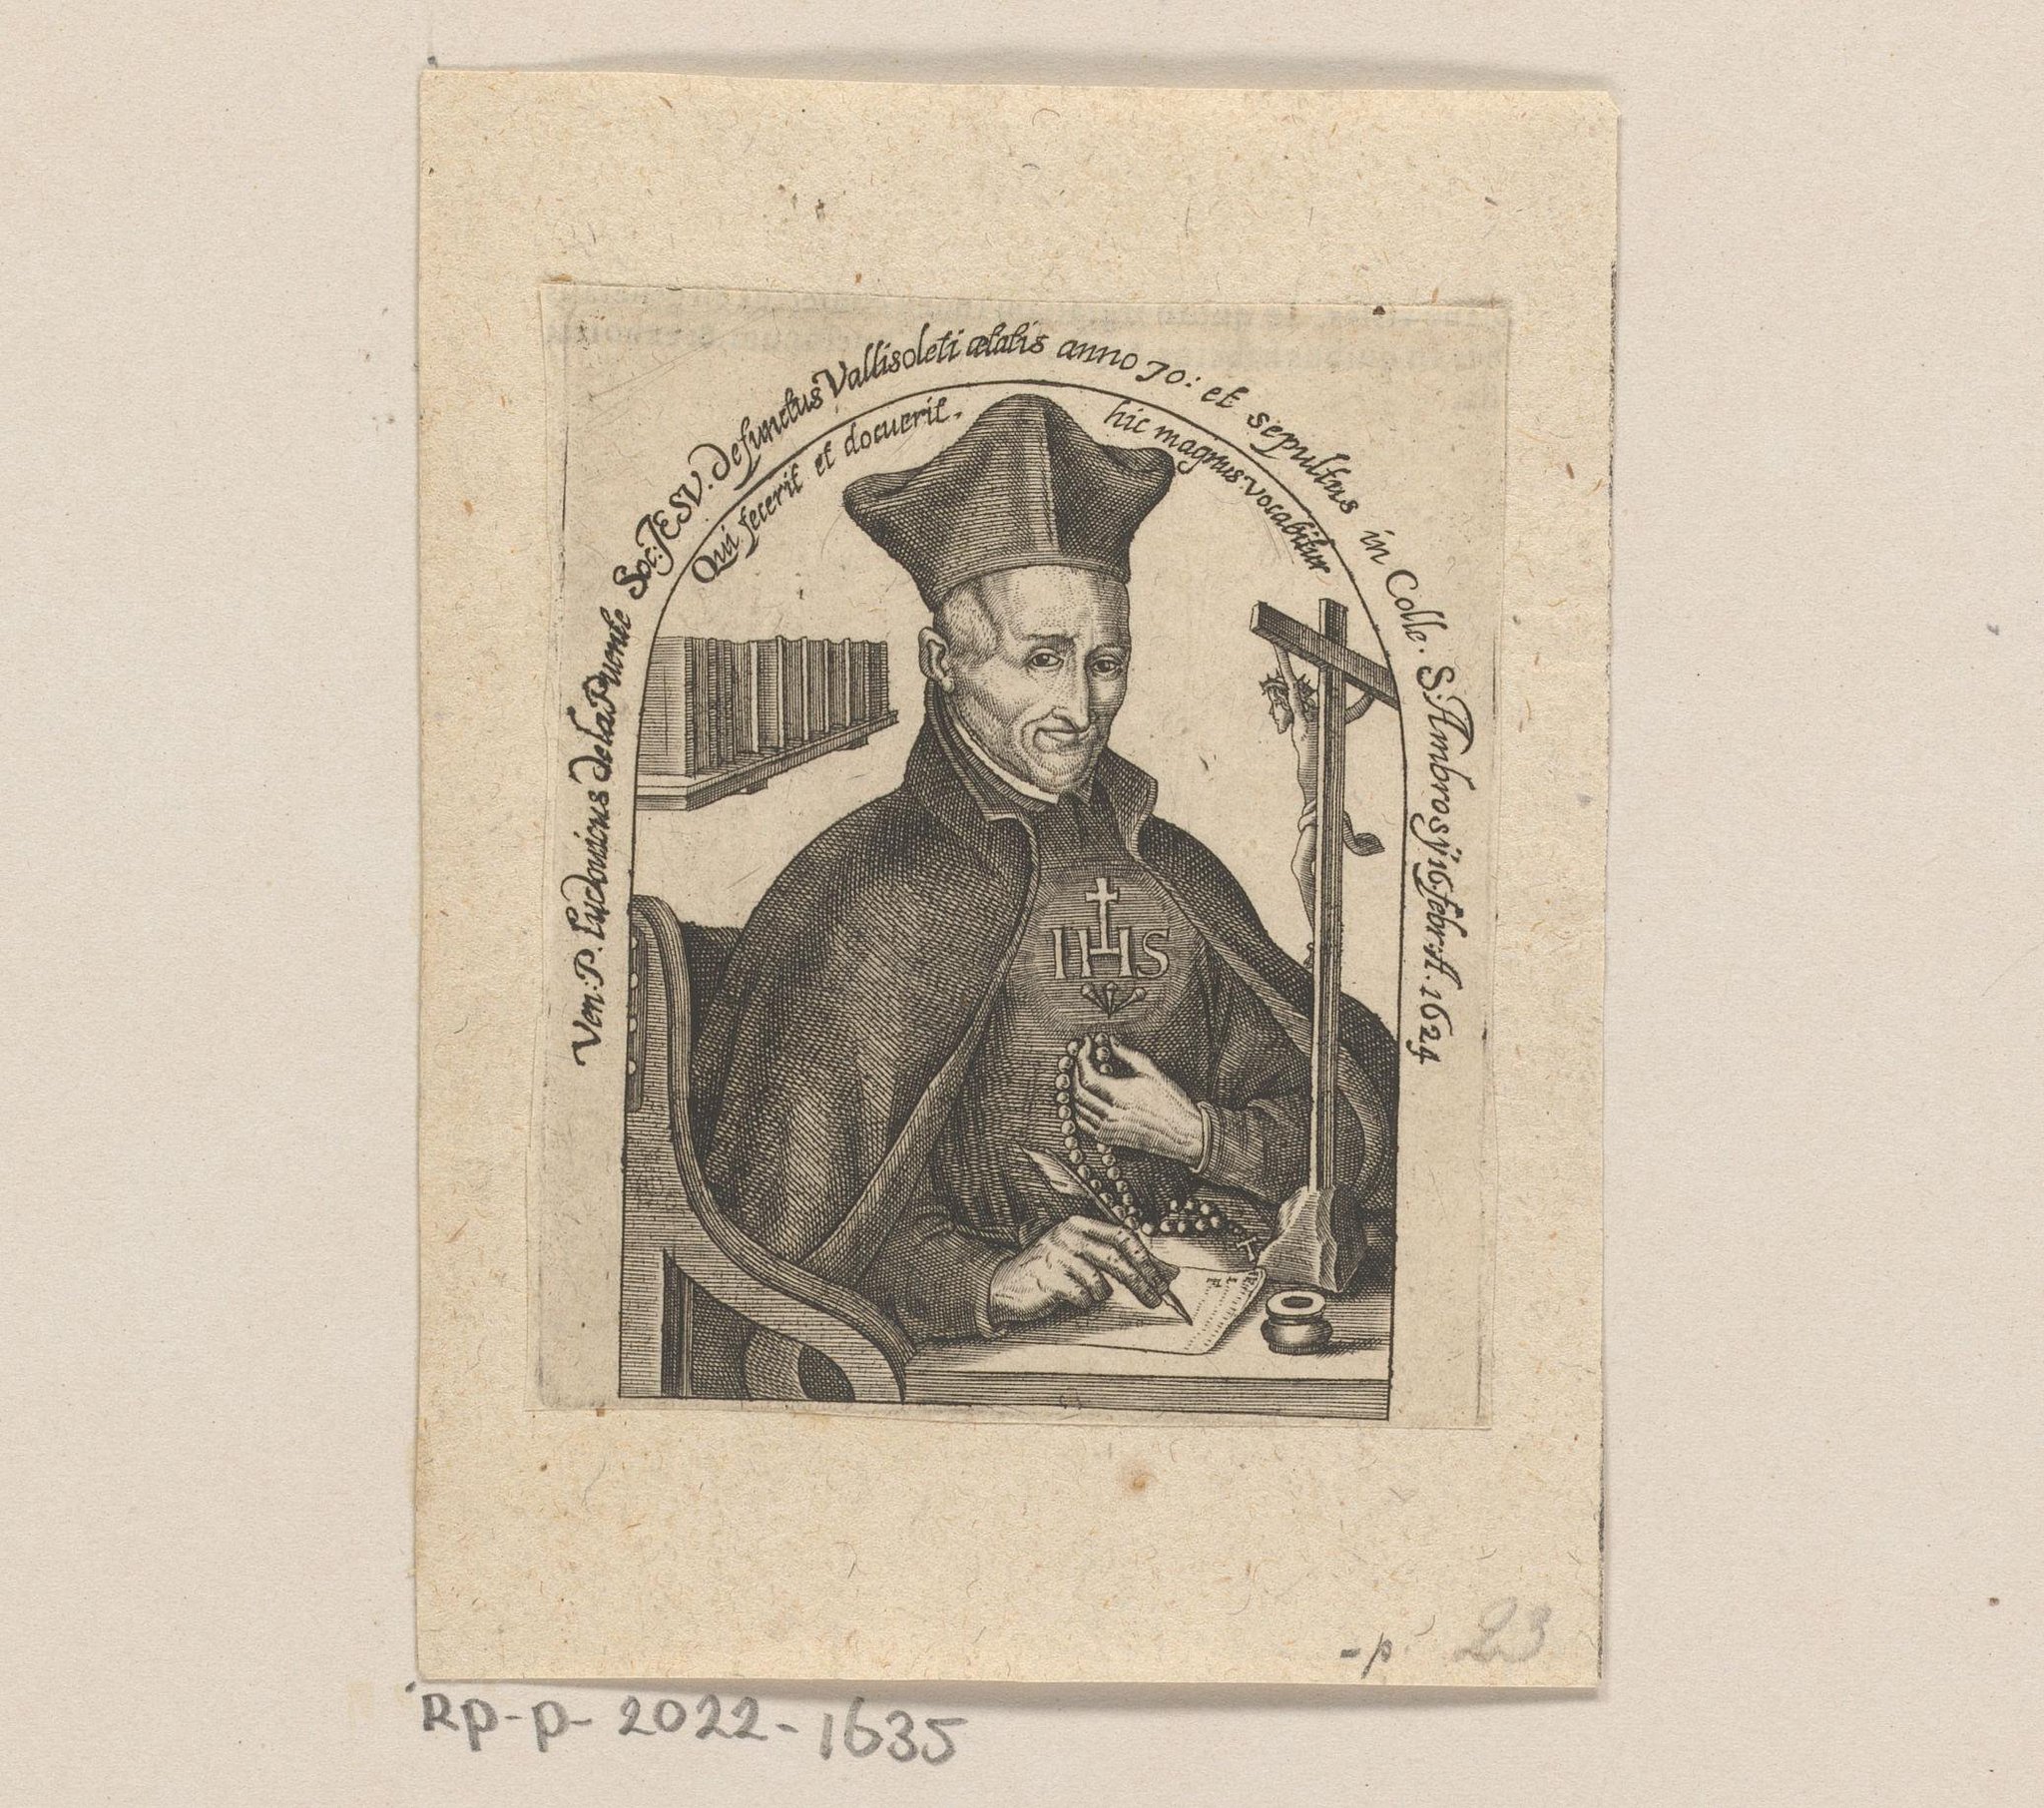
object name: book illustration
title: Portret van Luis de la Puente op 70-jarige leeftijd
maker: Anonymous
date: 1624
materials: paper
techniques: engraving, letterpress printing, snipping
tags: theologian, historical persons, portrait of a writer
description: Met tekst in het Latijn rondom het portret.